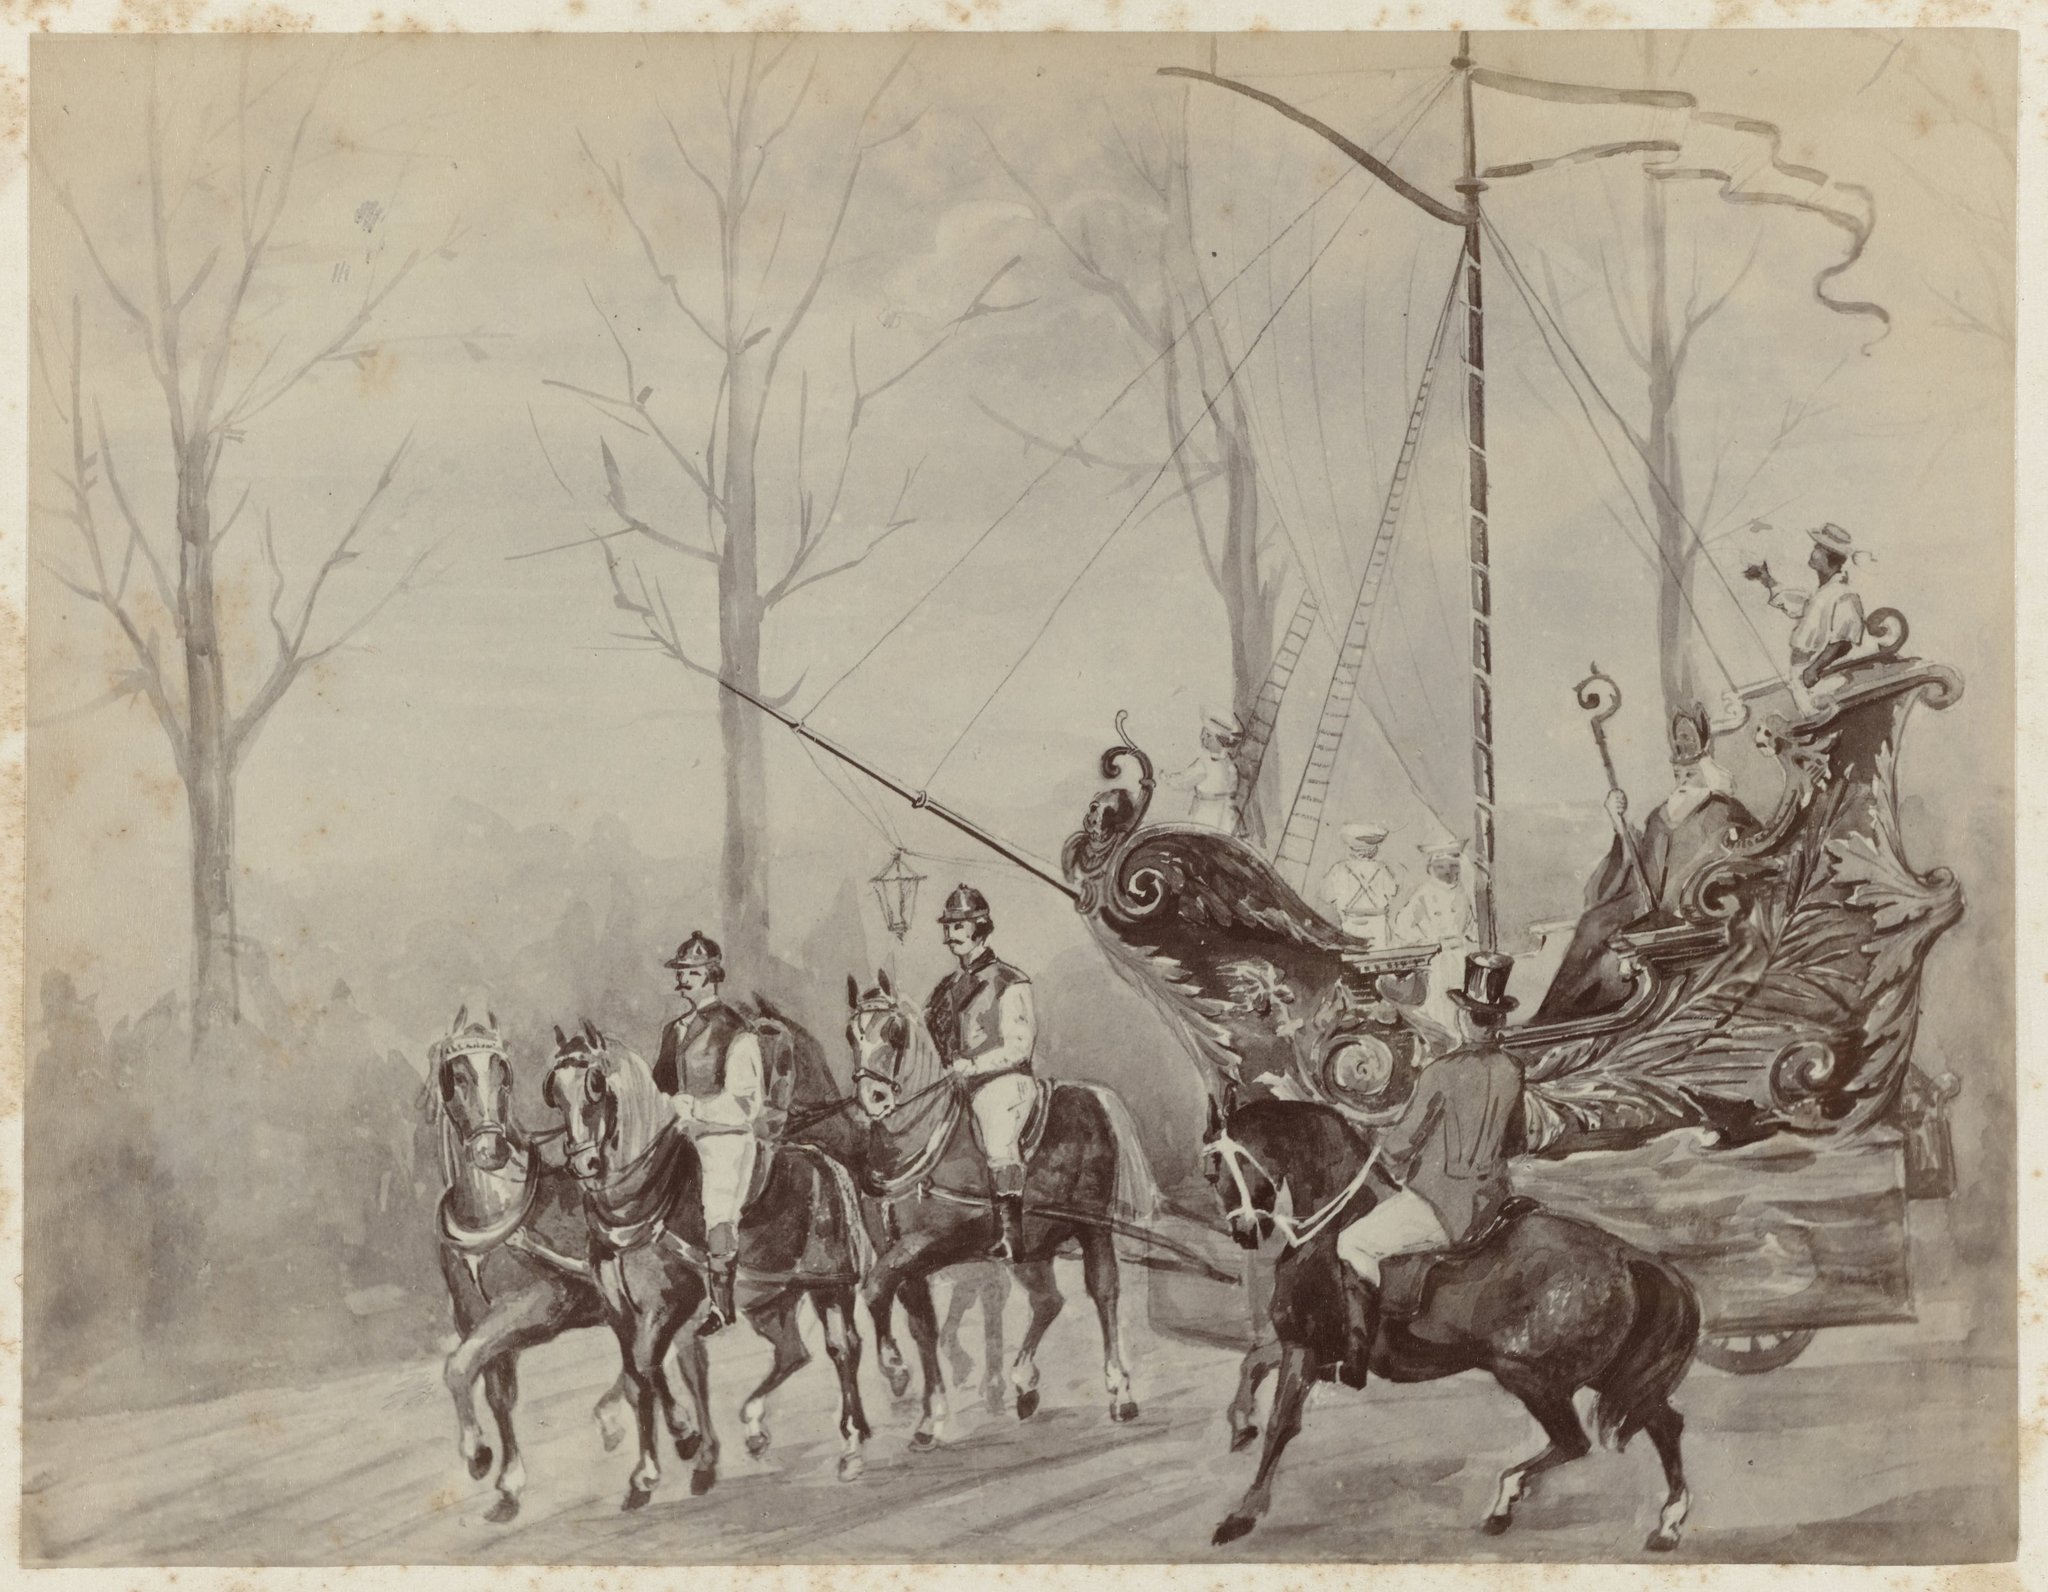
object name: photograph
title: Fotoreproductie van een aquarel van een praalwagen tijdens de onafhankelijkheidsfeesten in Dordrecht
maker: Anonymous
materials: cardboard, paper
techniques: albumen print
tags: triumphal entry and public reception, pageant, 'entrée solennelle', 'joyeuse entrée', dordrecht